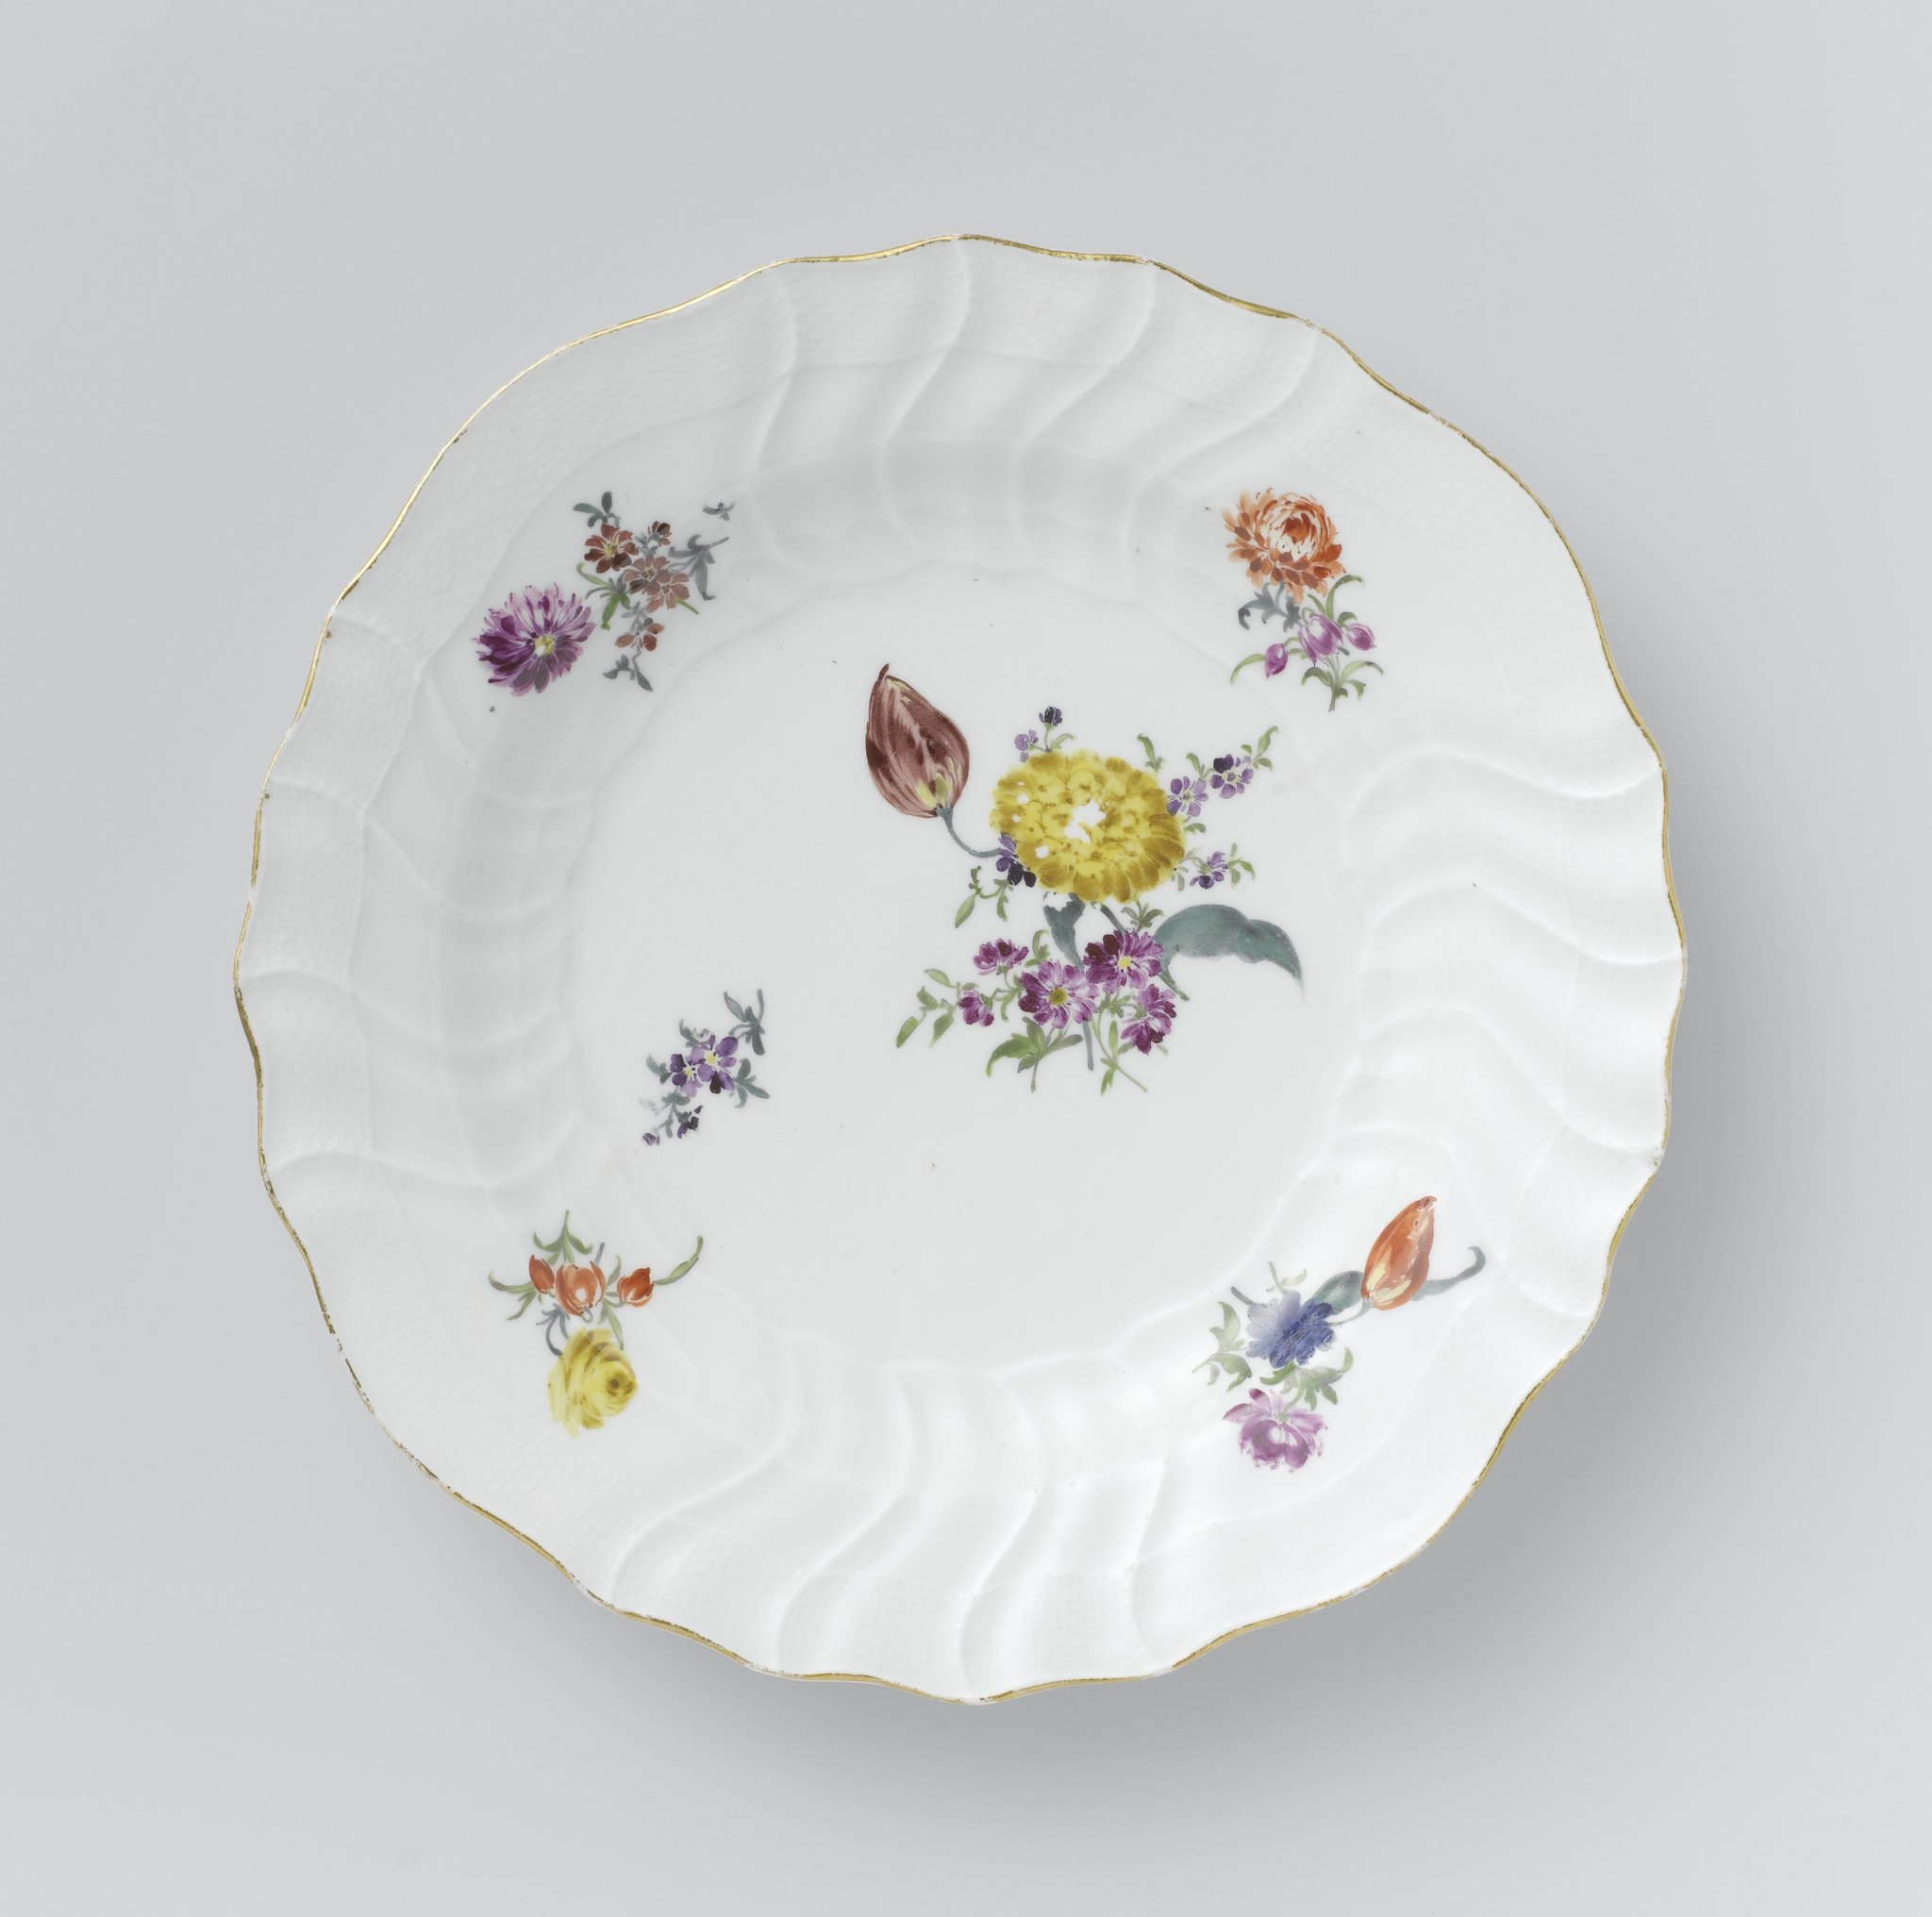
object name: plate dish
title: Bord, veelkleurig beschilderd met Deutsche Blumen, insekten en vruchten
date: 1750-1760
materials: porcelain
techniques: painted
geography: meissen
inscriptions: factory mark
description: Rond bord van beschilderd porselein. De rand is versierd met het Neuozier-patroon. De beschildering bestaat uit Deutsche Blumen, insekten en vruchten. Het bord is gemerkt en hoort bij een servies (BK-17474-1 t/m BK-17474-253).